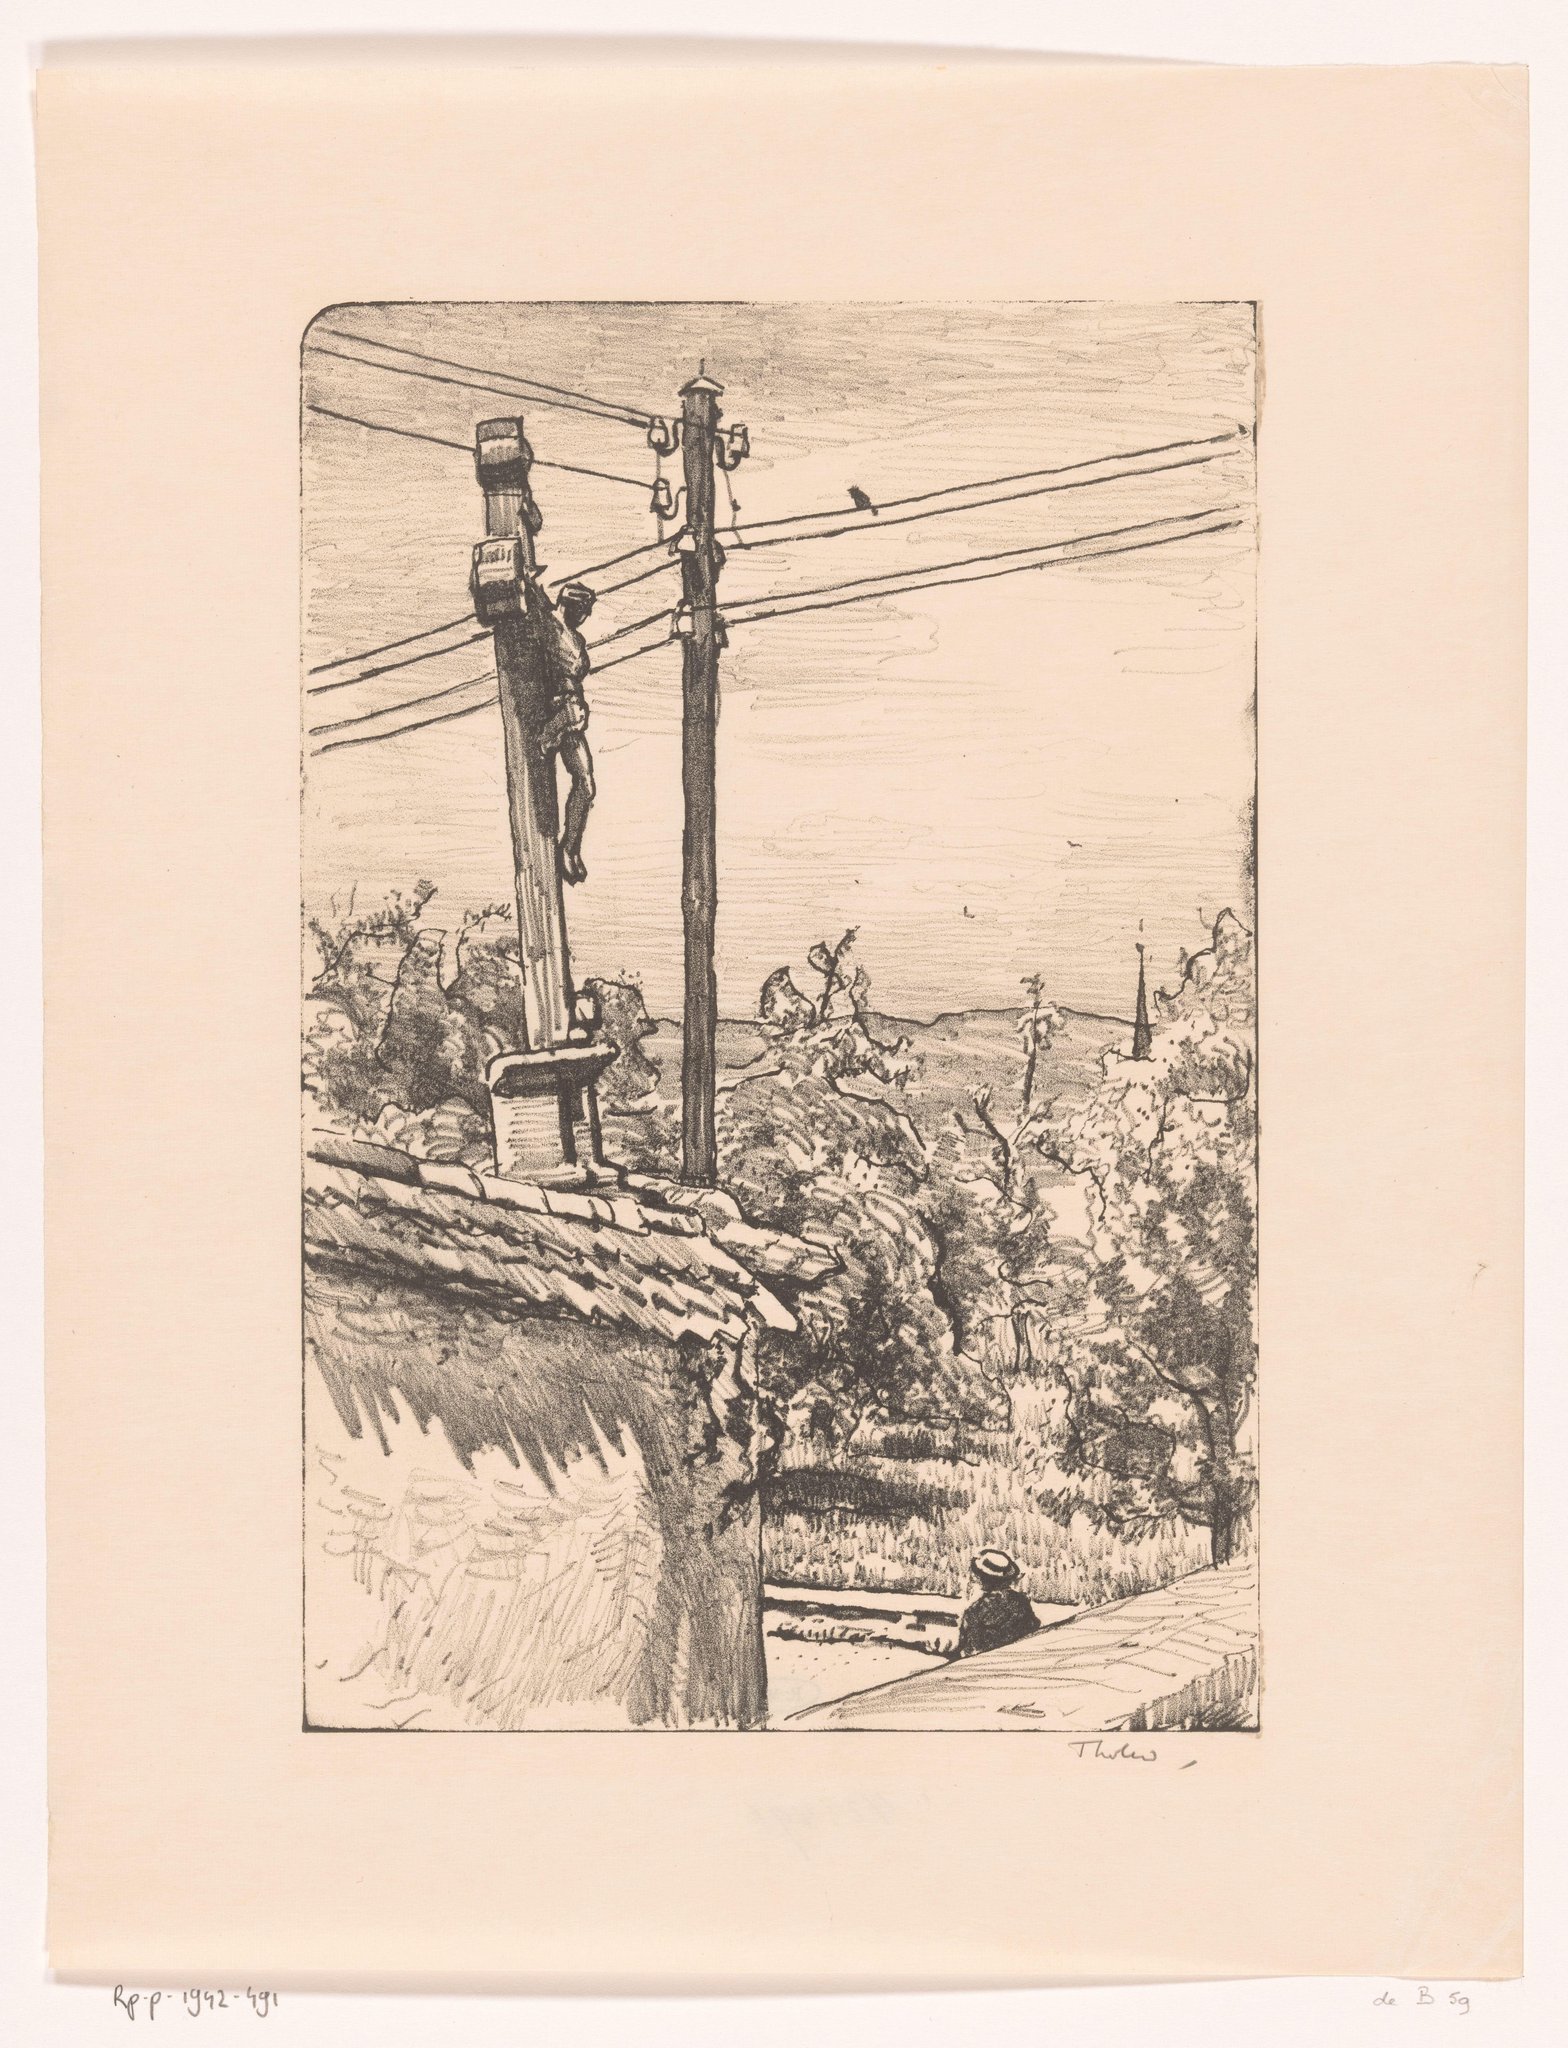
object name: print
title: Landschap met telegraafpaal en kruis met Christusbeeld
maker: willem bastiaan tholen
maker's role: draughtsman, painter, print maker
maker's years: 1860-1931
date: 1870-1914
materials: paper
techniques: lithograph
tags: low hill country, telegraph pole, telephone pole, crucifix ~ personal devotion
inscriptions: collector's mark: Lugt 2228